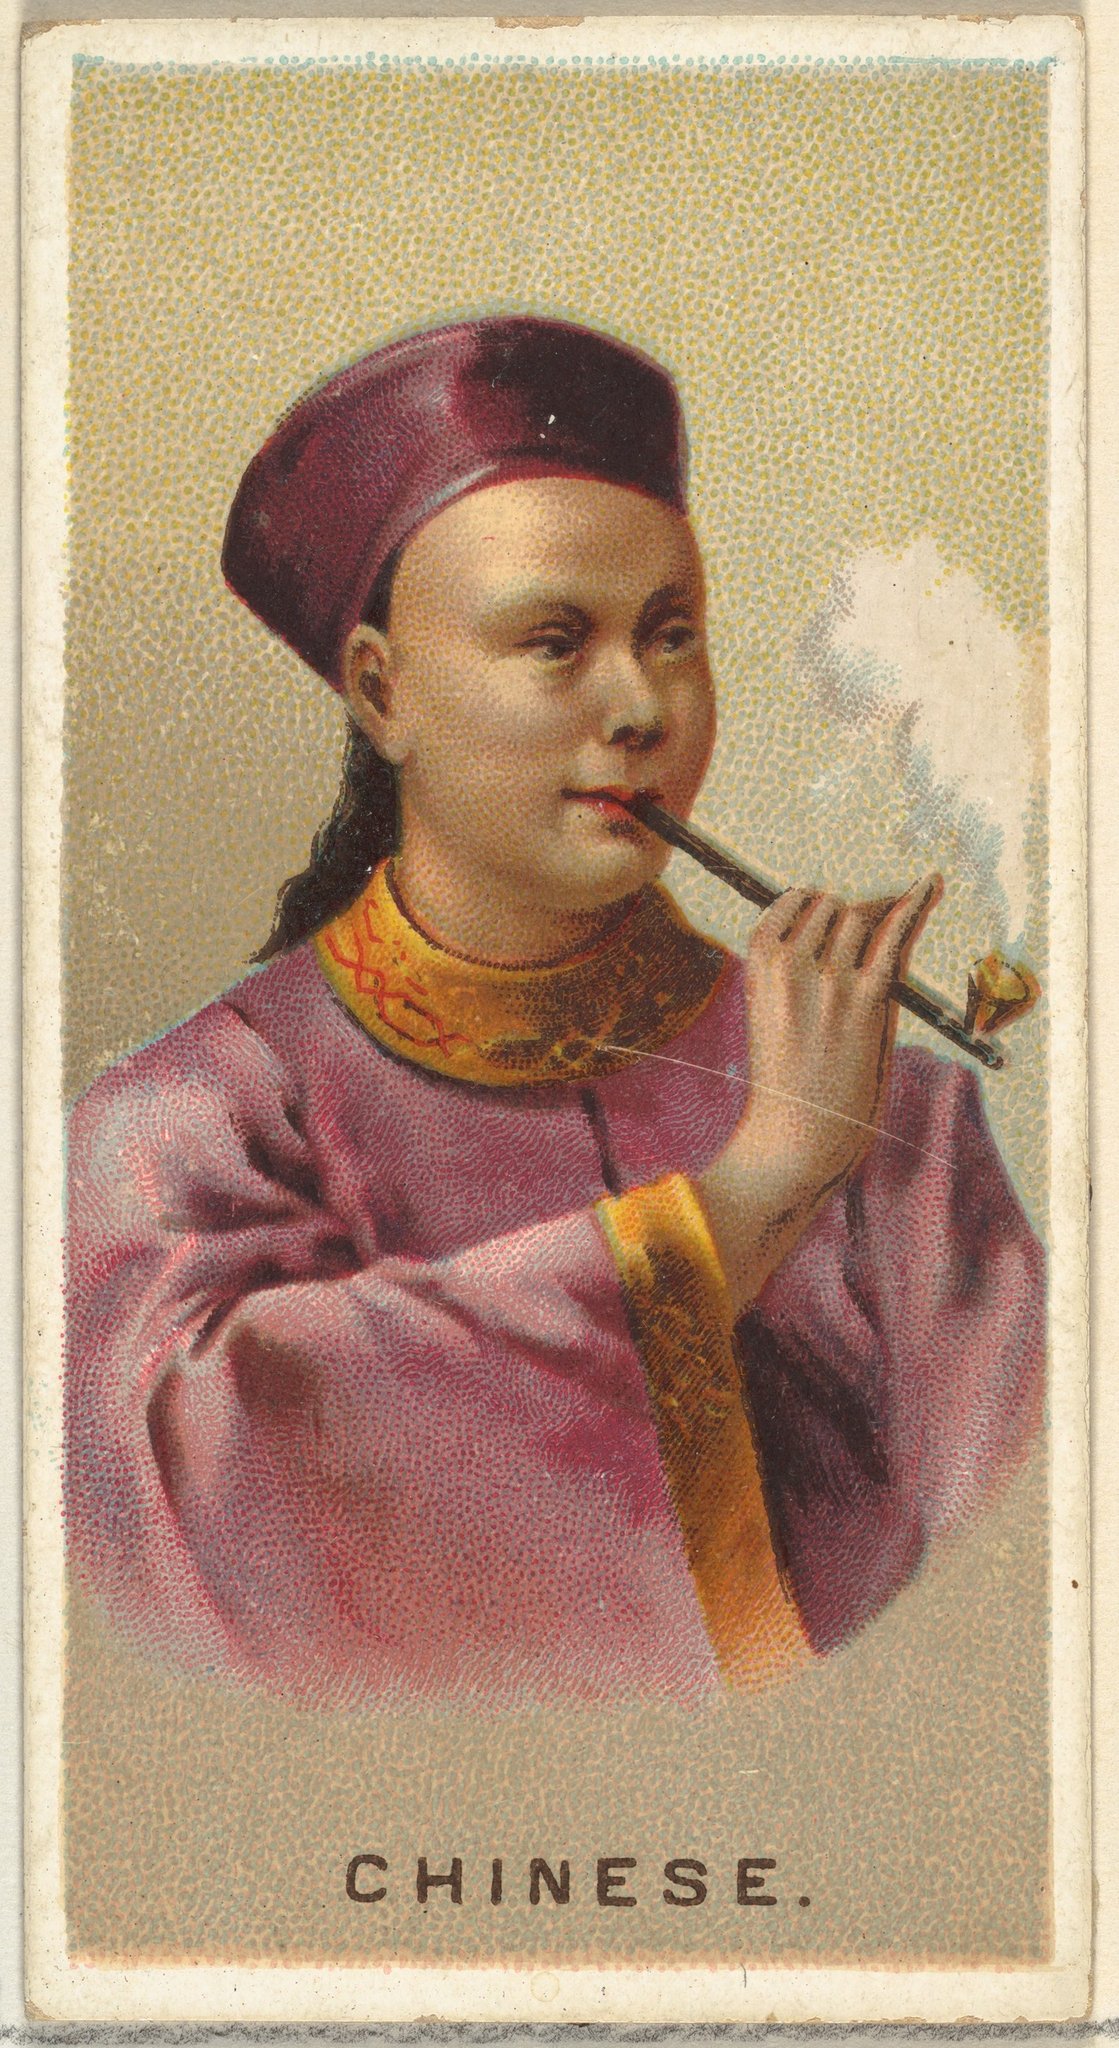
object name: print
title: Chinese, from World's Smokers series (N33) for Allen & Ginter Cigarettes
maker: allen & ginter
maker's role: publisher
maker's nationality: american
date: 1888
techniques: color lithograph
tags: men,smoking